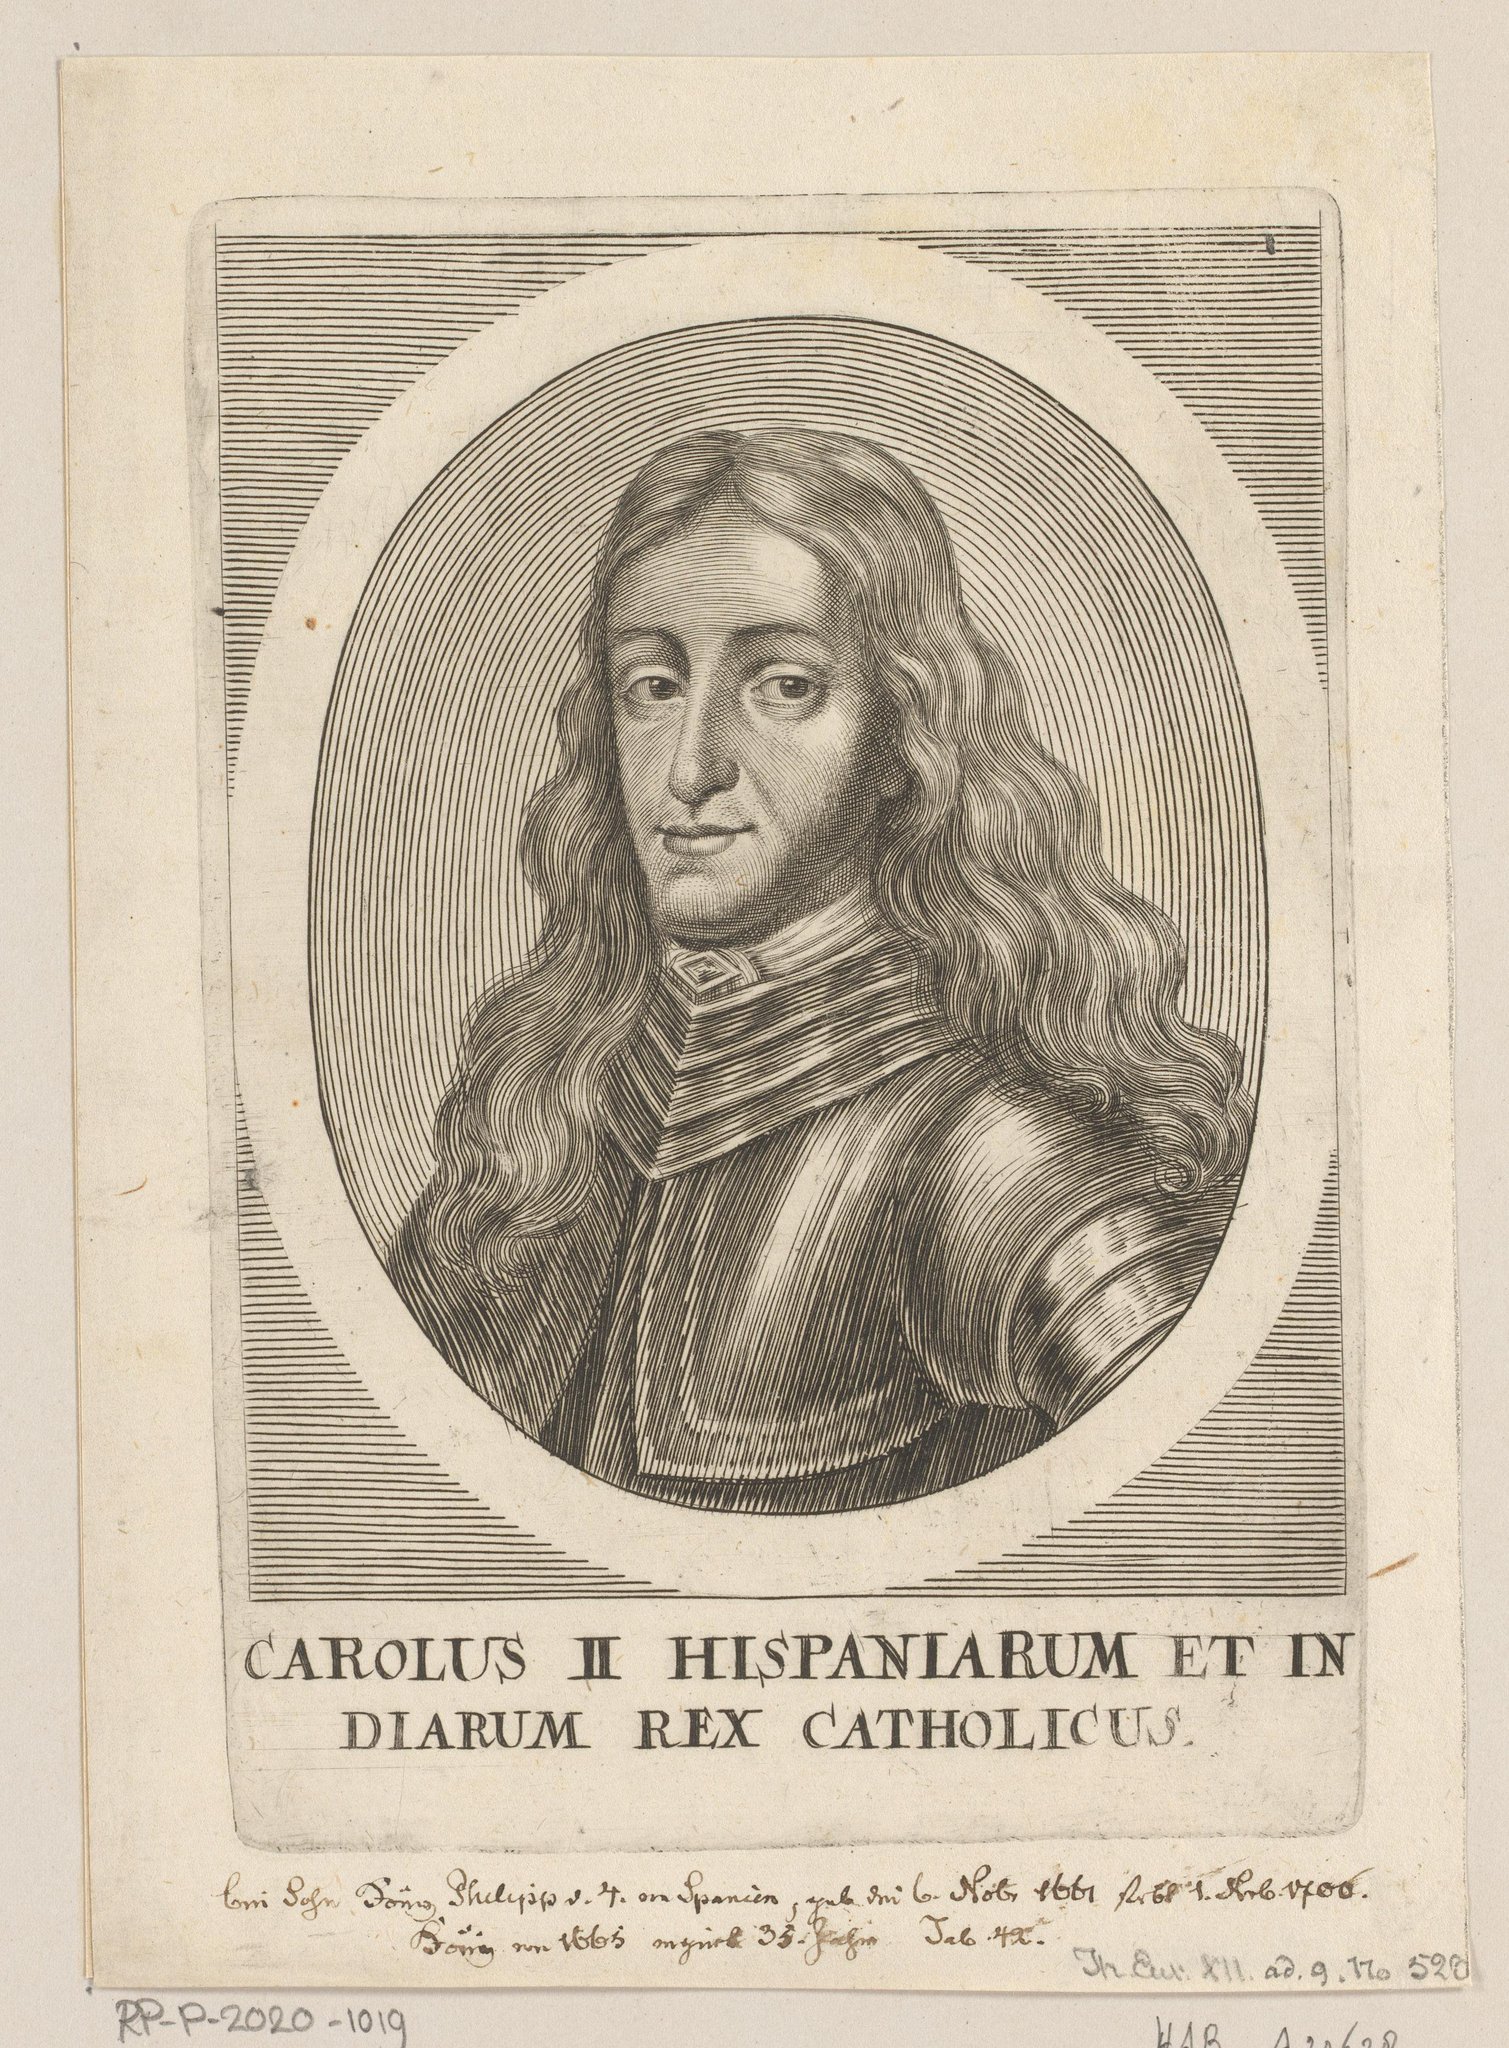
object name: print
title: Portret van Karel II, koning van Spanje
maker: erven matthäus merian (i)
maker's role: print maker, printer, publisher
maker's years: 1650-1734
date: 1691-1707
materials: ink, paper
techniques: engraving, pen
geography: frankfurt am main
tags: karel ii (koning van spanje), historical persons, ruler, sovereign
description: Prent ook gebruikt in: Theatrum Europaeum (...). Frankfurt am Main: erven Matthäus Merian I, Johann Phillip Abelinus en Heinrich Oraeus, 1691, dl. 12. Ook in: Theatrum Europaeum (...). Frankfurt am Main: erven Matthäus Merian I, Johann Phillip Abelinus en Heinrich Oraeus, 1707, dl. 15.